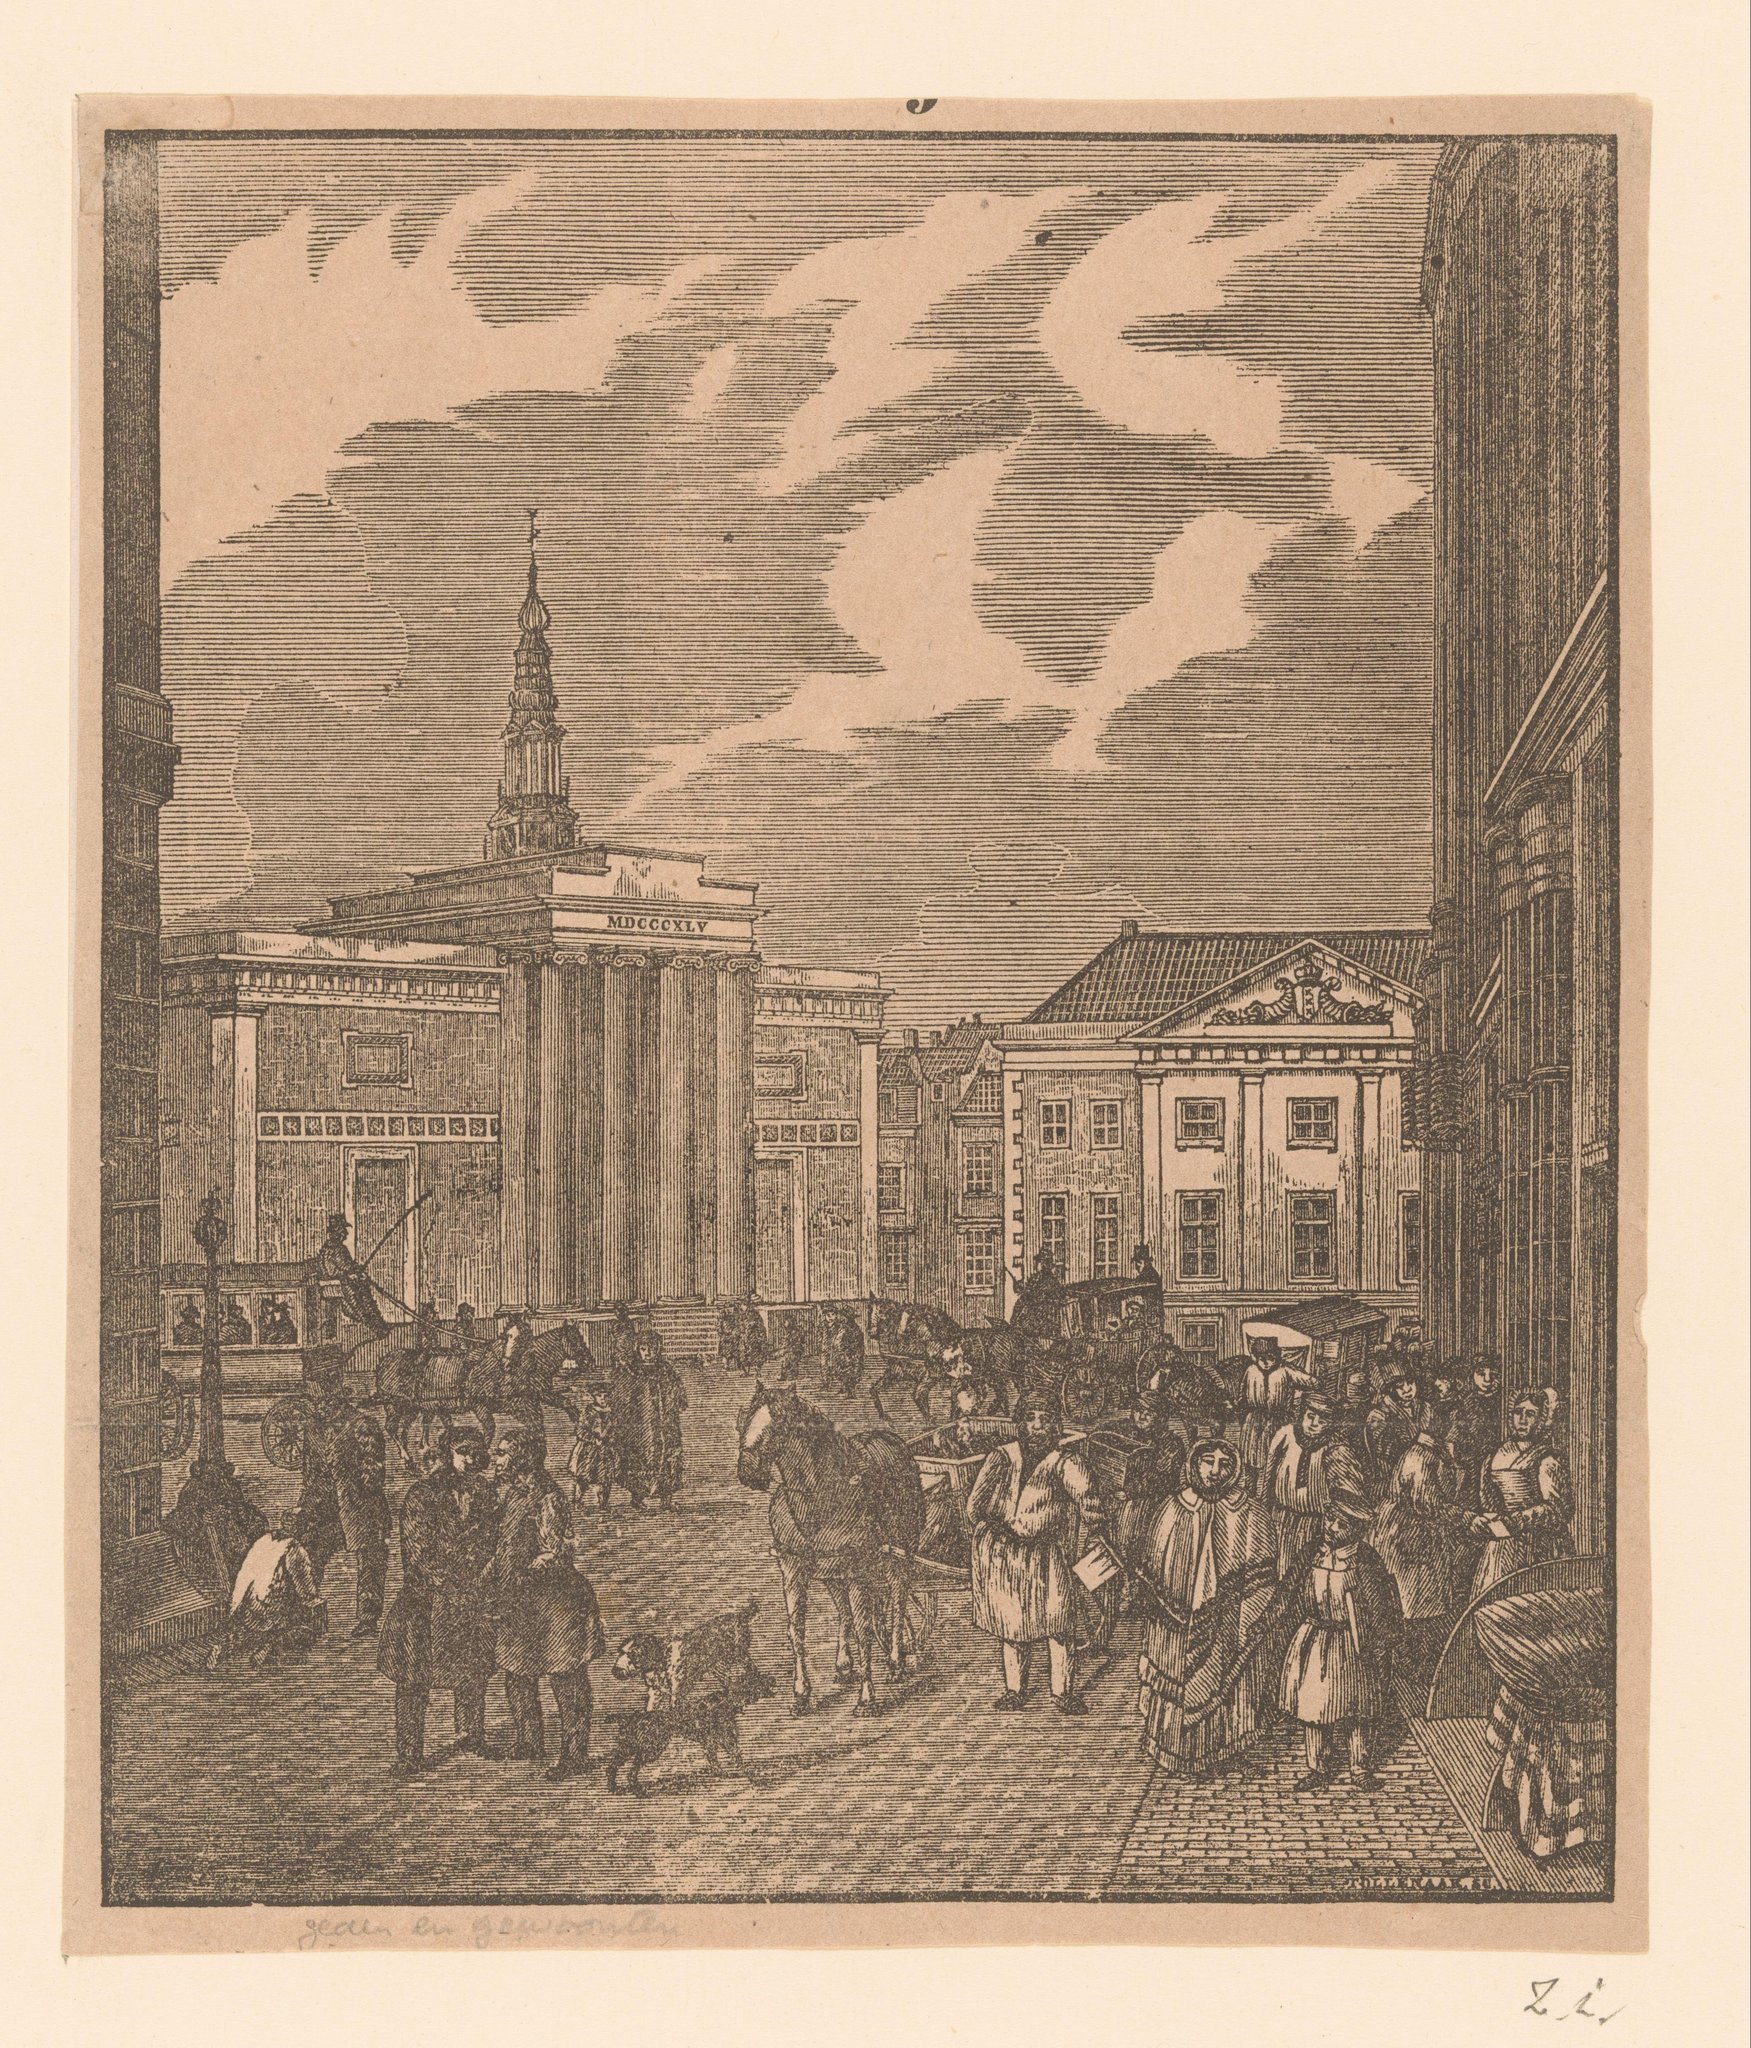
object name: new year card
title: Fragment van een nieuwjaarswens van de Amsterdamse askarrenmannen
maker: dirk wijbrand tollenaar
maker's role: print maker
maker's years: 1808-1858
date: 1840-1870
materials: paper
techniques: engraving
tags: tower, clock tower ~ monumental adornment, stock exchange, stock-market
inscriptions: collector's mark: Lugt 2228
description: Deze prent is meerdere jaren gebruikt voor een nieuwjaarswens van de Amsterdamse askarrenmannen, tussen ca. 1842 en 1869, zie collectie Rijksmuseum Amsterdam.